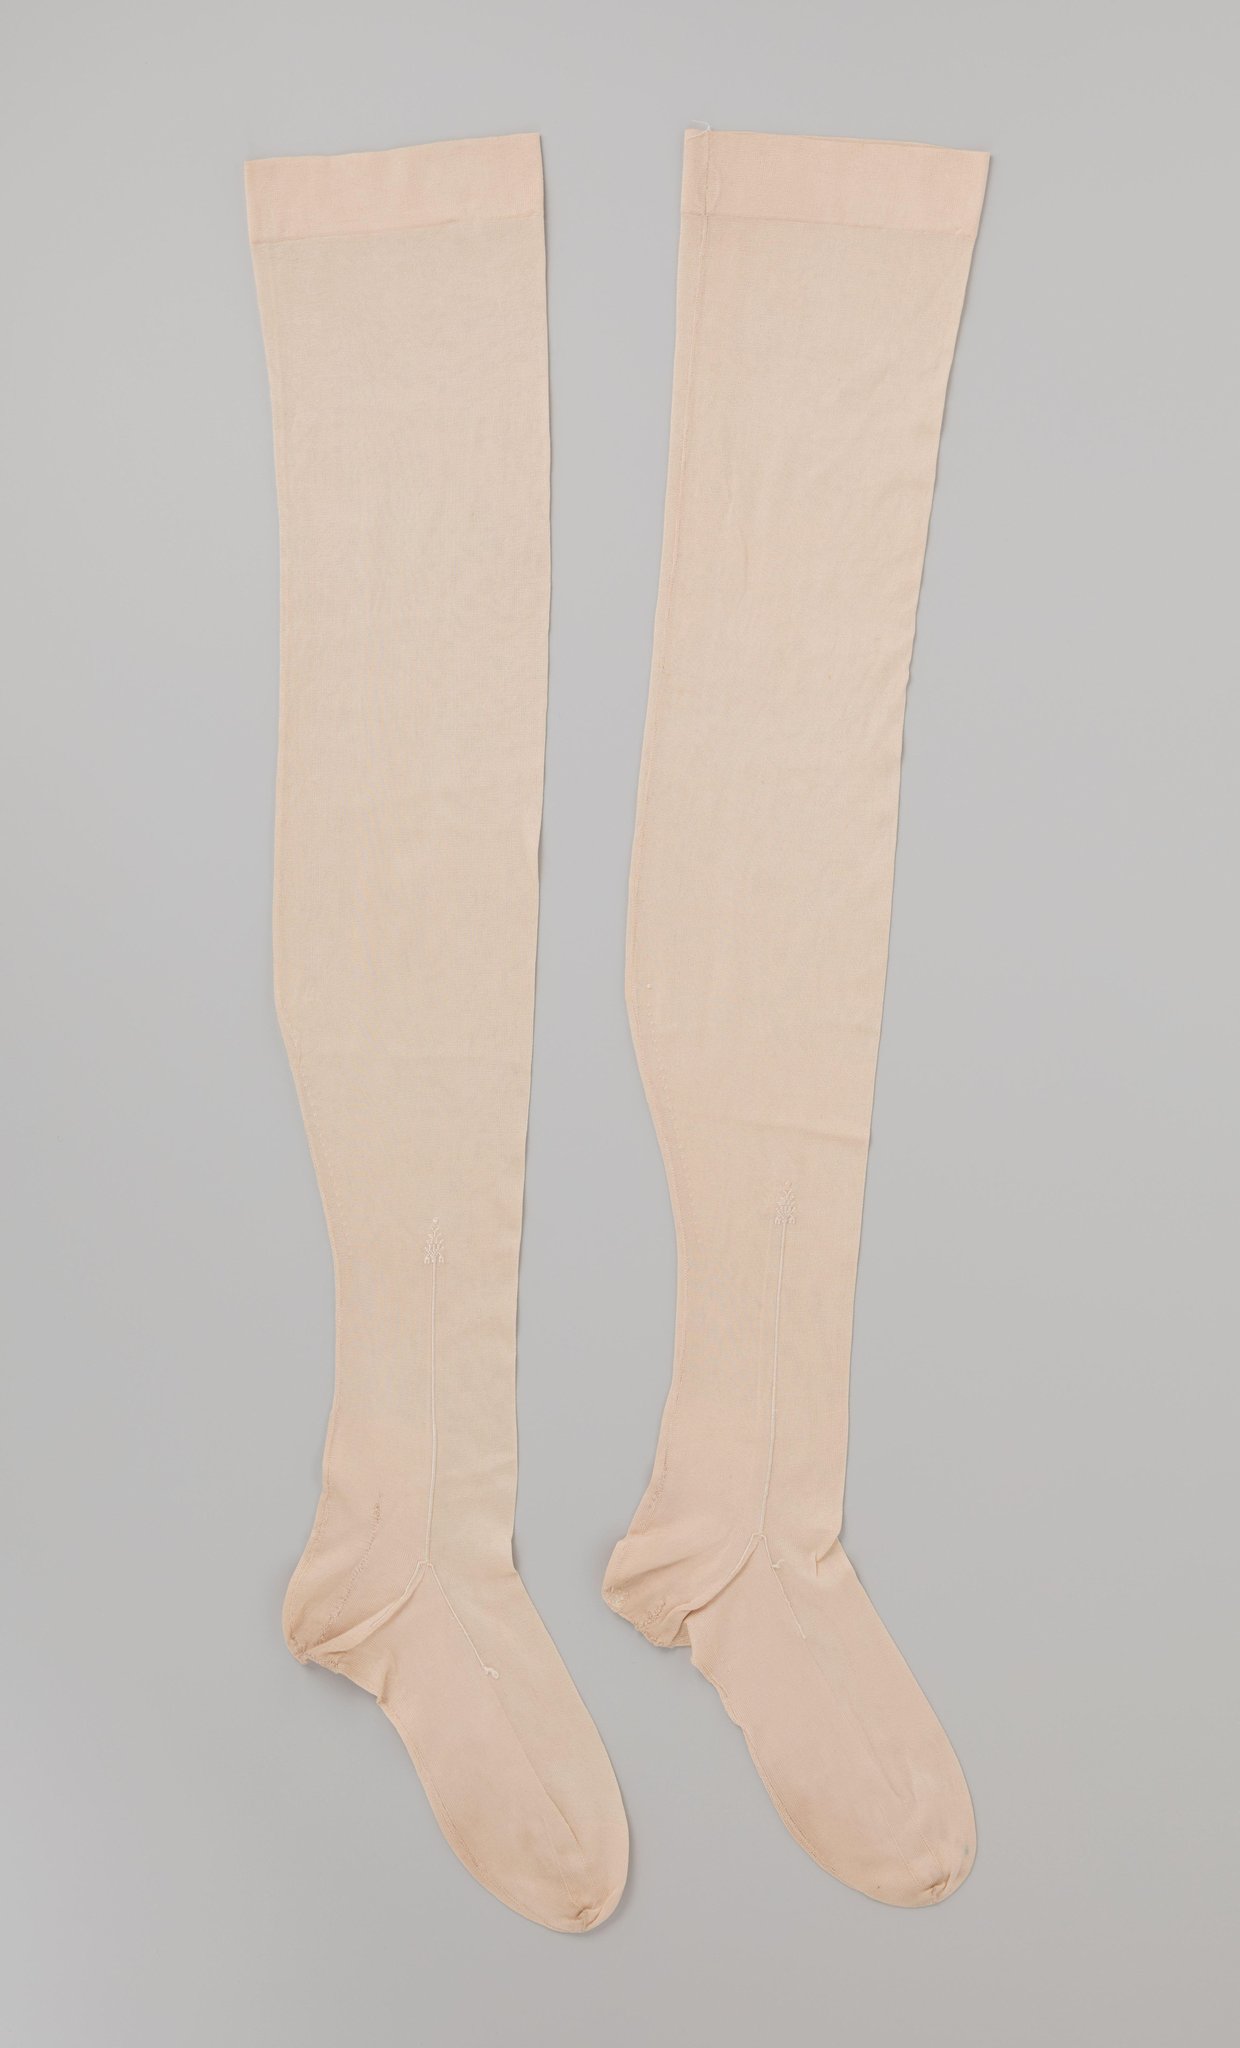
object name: clothing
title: Kous van effen ivoorkleurige zijde met een enkele geborduurde pijl op de klink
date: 1800-1820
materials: silk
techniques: embroidered, knitting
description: Kous van effen ivoorkleurige zijde met een enkele geborduurde pijl op de klink. Naad middenachter.